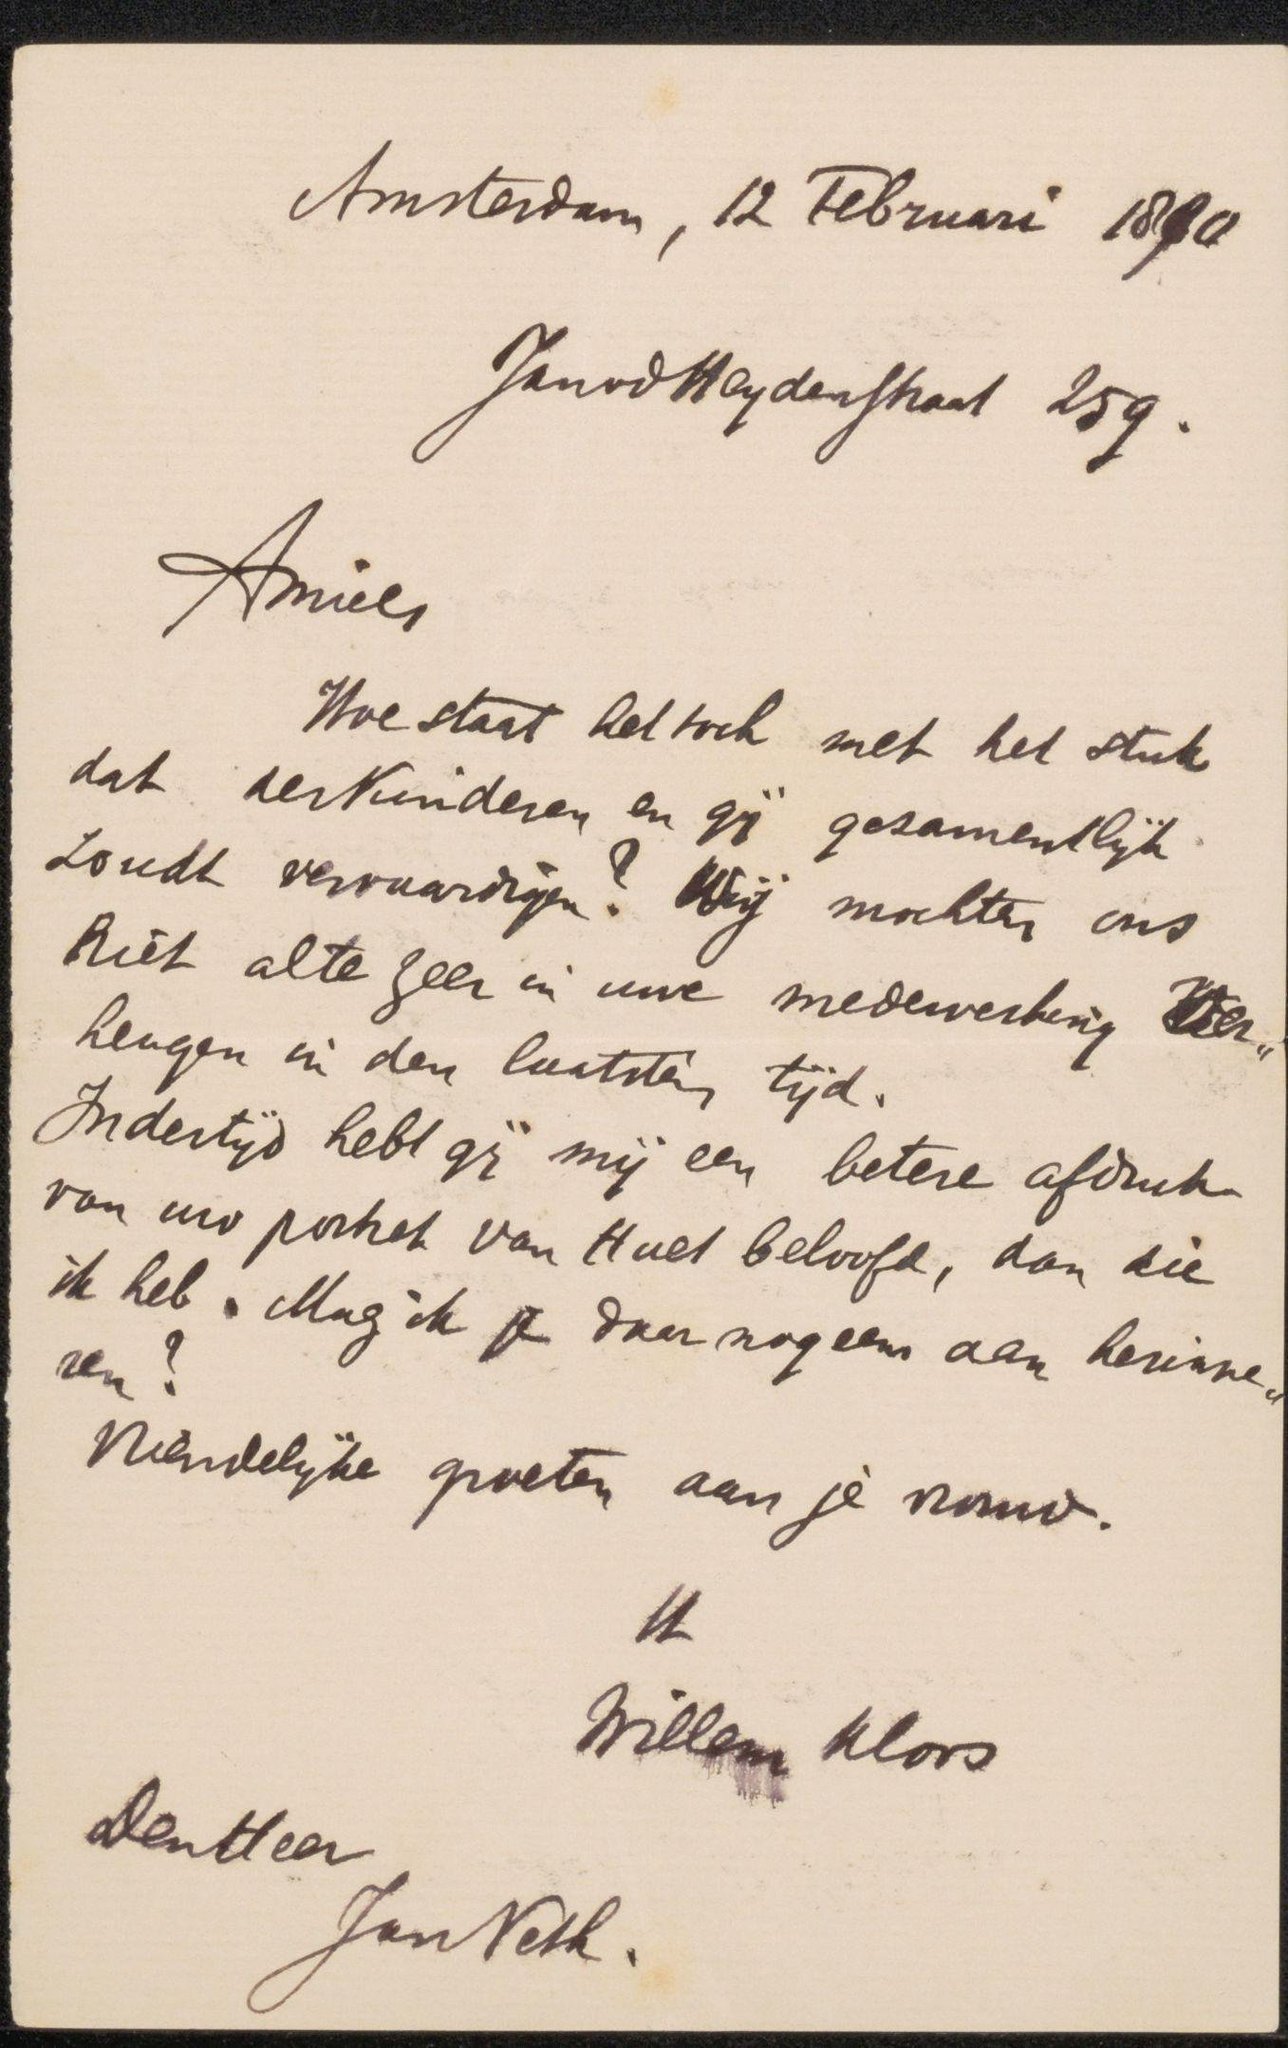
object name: letter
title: Brief aan Jan Veth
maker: willem kloos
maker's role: dichter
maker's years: 1859-1938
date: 1890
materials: ink, paper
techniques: pen, writing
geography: amsterdam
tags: designer, jan veth, den bosch, painter, print maker, draughtsman, antoon derkinderen, paris, historical persons (portraits and scenes from the life)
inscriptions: collector's mark: ‘RPK’, watermark